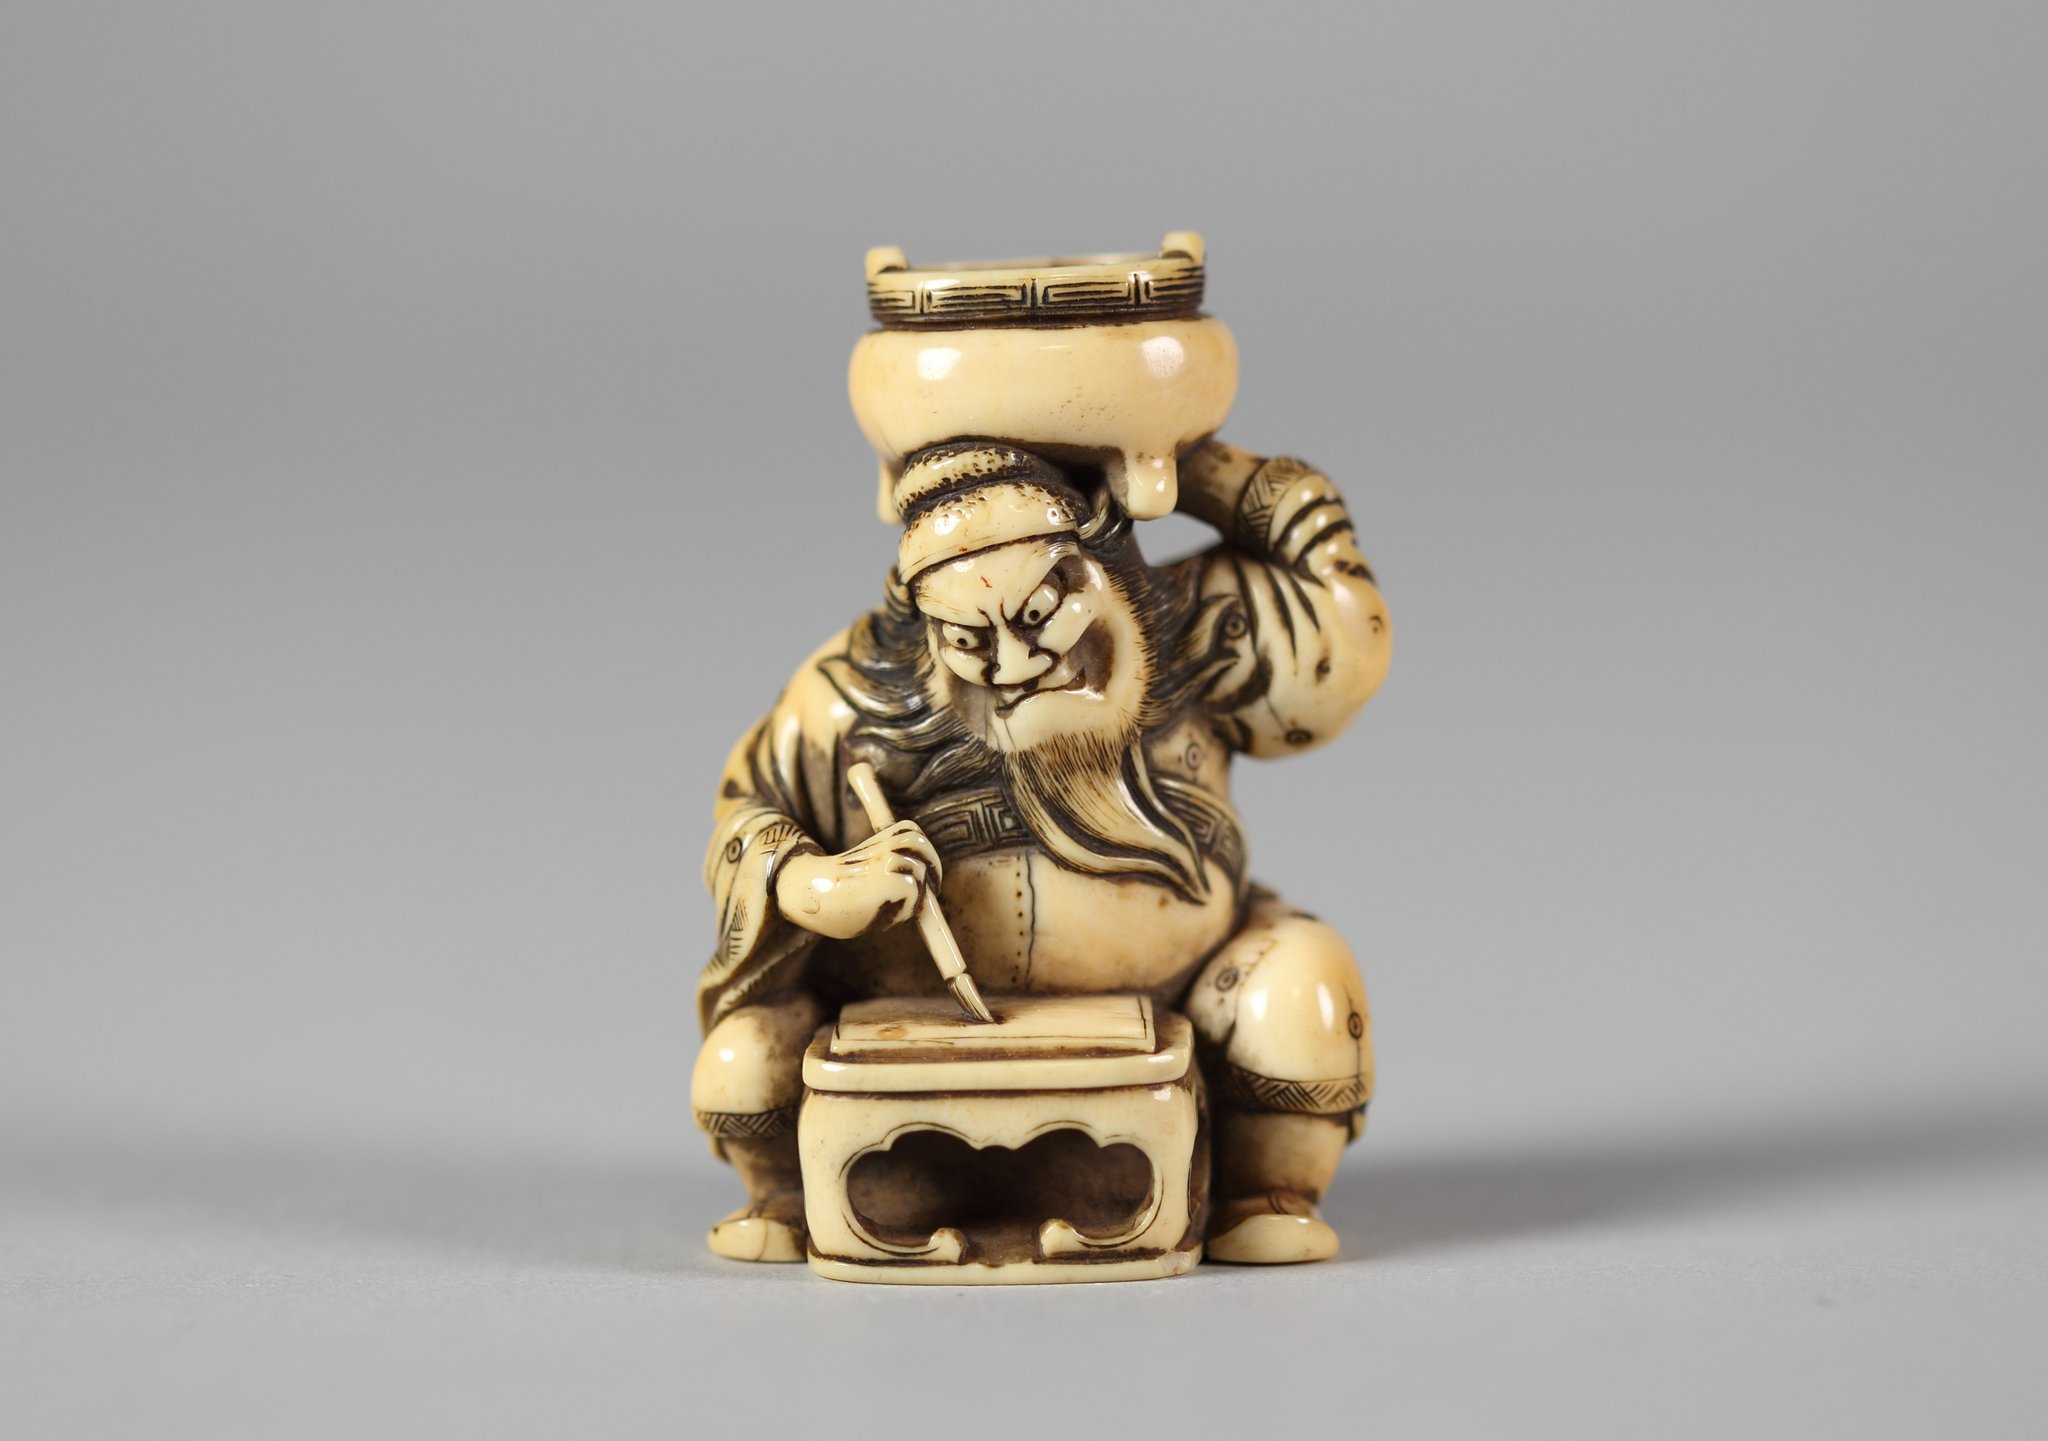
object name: netsuke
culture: japanese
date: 1801-1900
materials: ivory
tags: men,writing